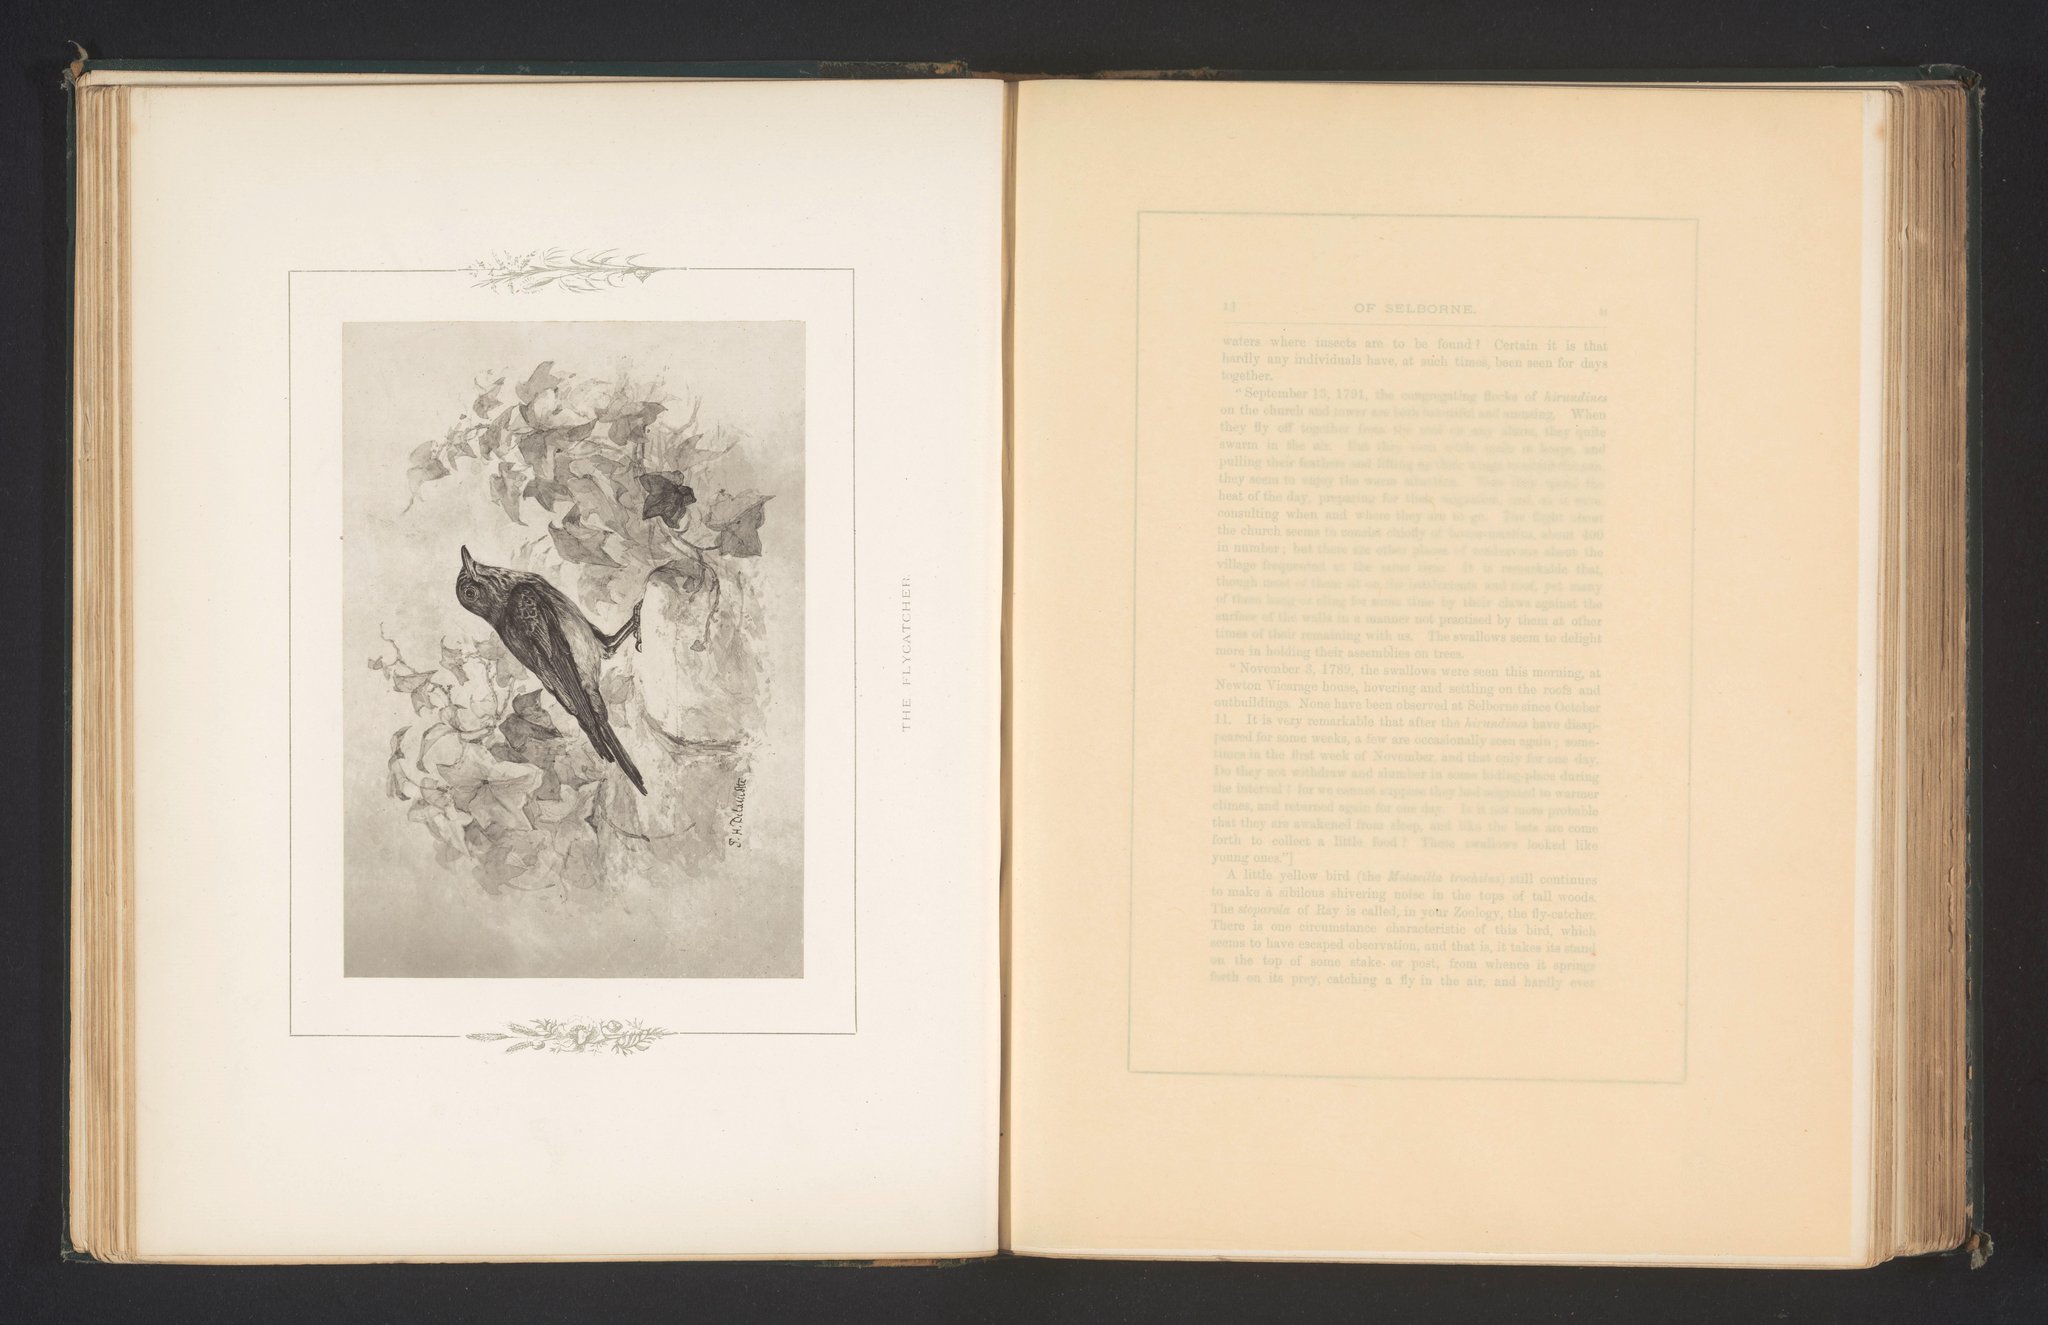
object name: page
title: The flycatcher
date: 1850-1876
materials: photographic support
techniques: carbon print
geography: selborne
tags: birds